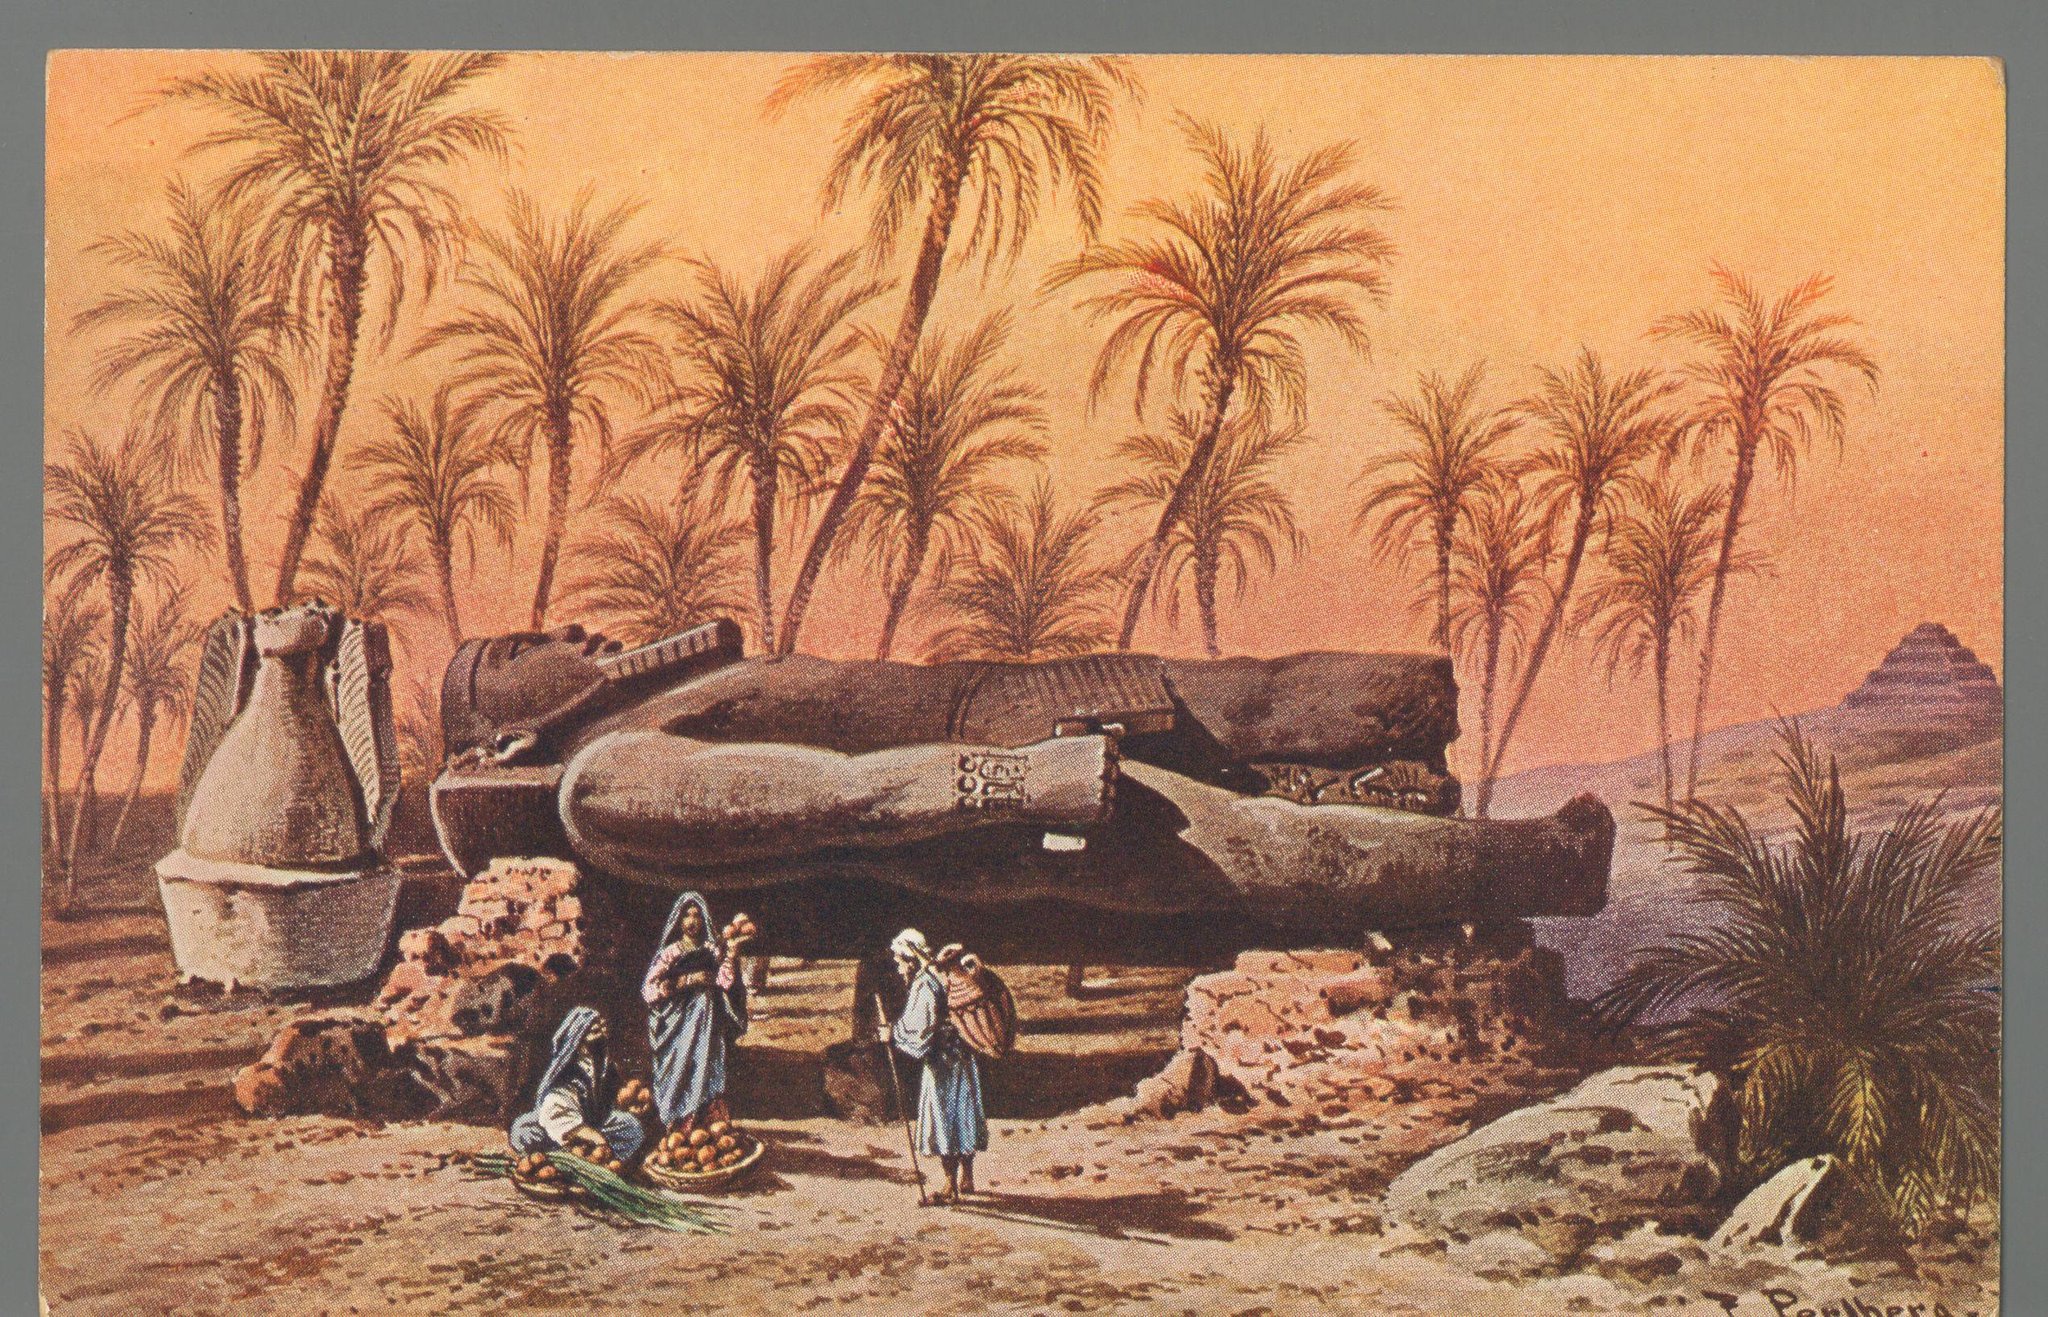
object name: photomechanical print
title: Statue de Ramses à Memphis / Statue of Ramses at Memphis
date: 1907-1930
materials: cardboard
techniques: color autotype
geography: dresden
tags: quadrangular pyramid, statues, paintings, etc. ~ objects of worship (egyptian religion)